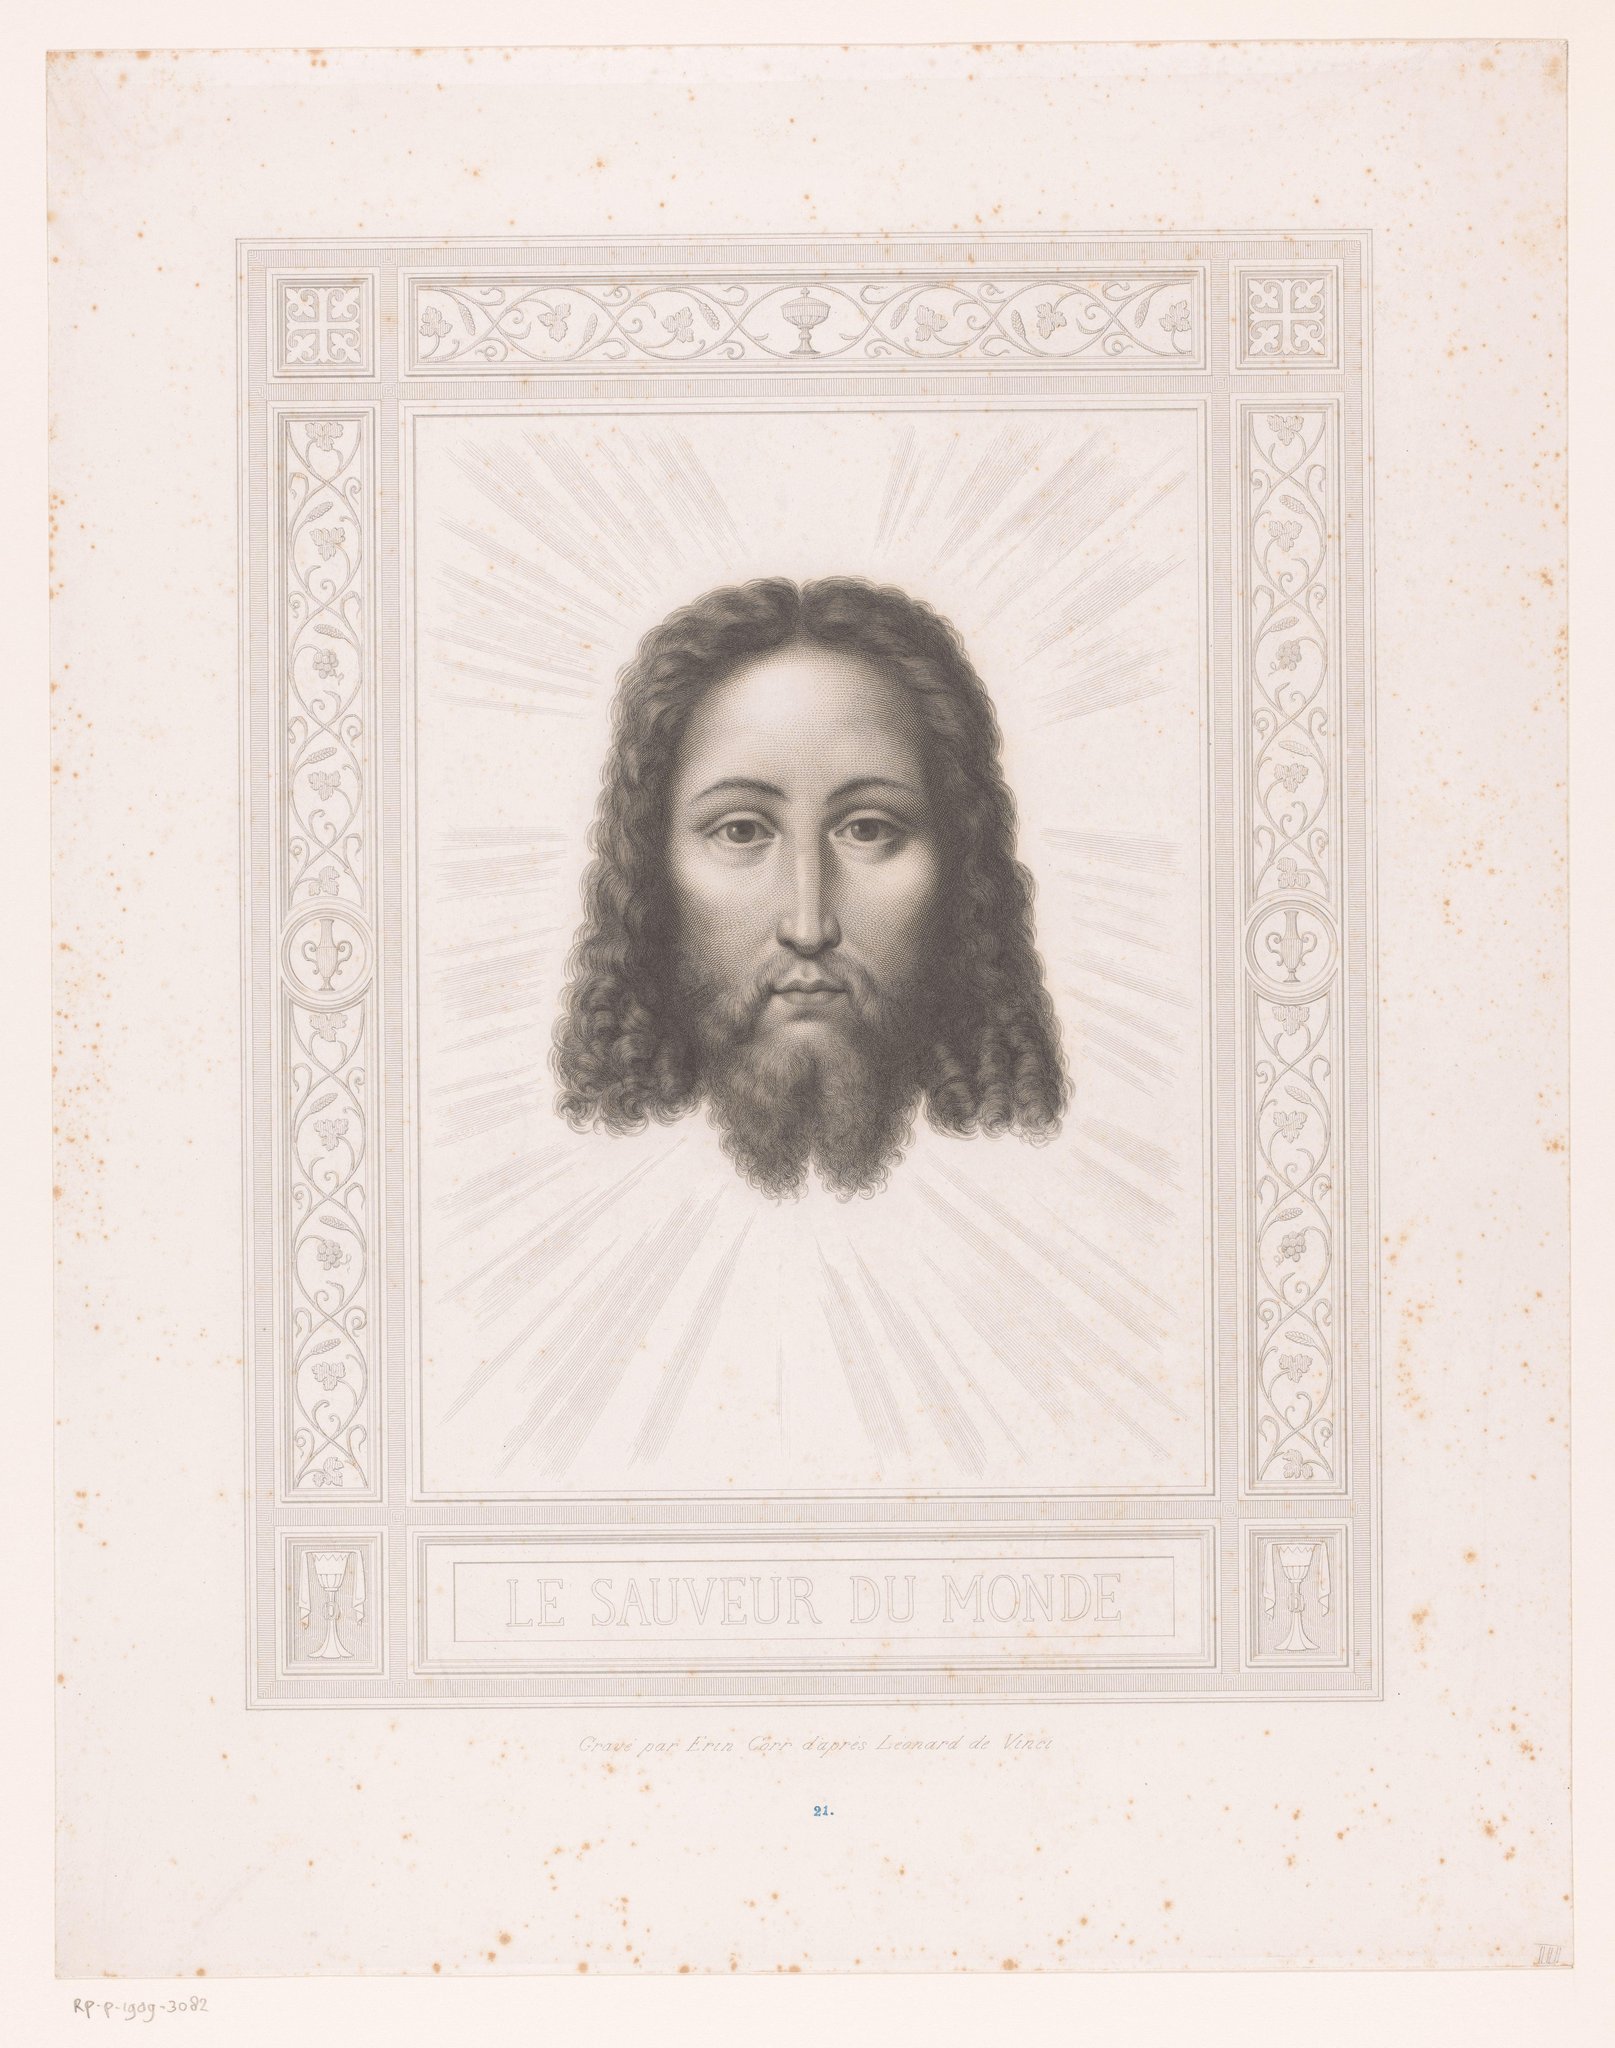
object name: print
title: Christuskop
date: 1815-1862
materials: paper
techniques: engraving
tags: 'portraits' of christ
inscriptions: mark: ‘21’, collector's mark: Lugt 2228